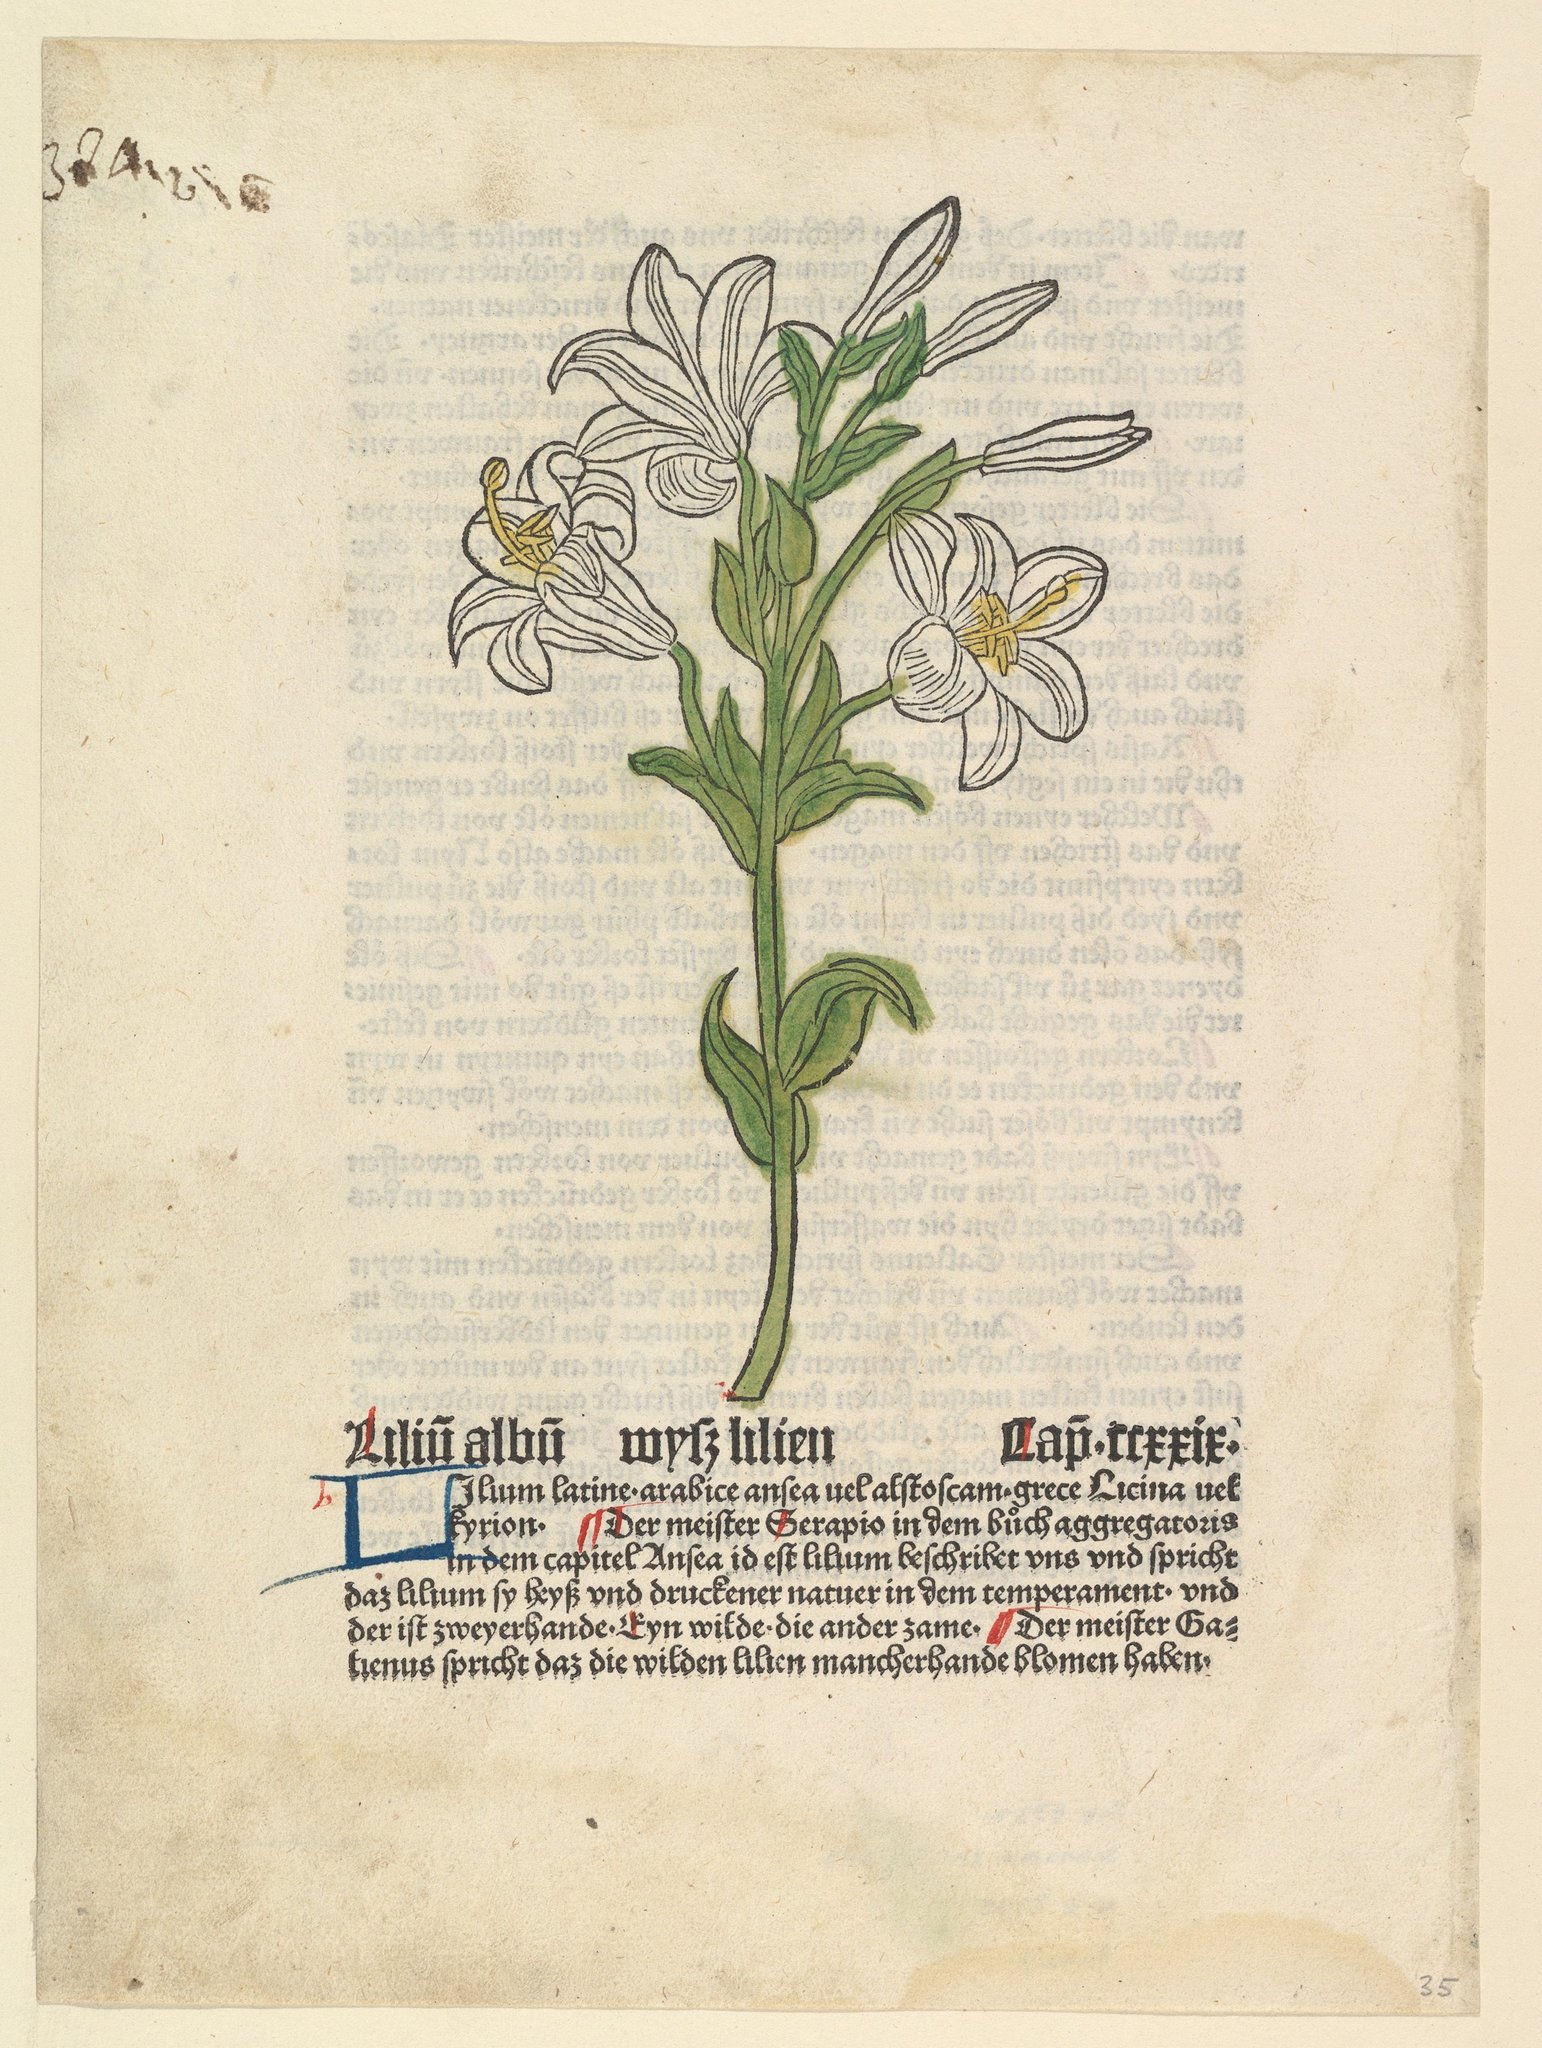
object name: print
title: White Lily, from "Gart der Gesundheit"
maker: anonymous, german, 15th century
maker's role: artist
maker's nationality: german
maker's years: 1400-1500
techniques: hand coloring, woodcut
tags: lilies